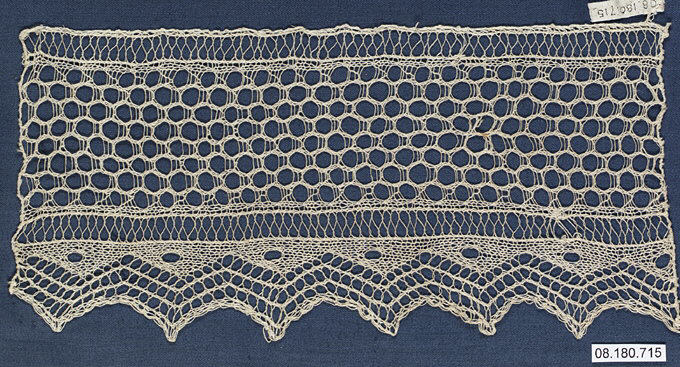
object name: fragment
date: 1801-1900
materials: lace